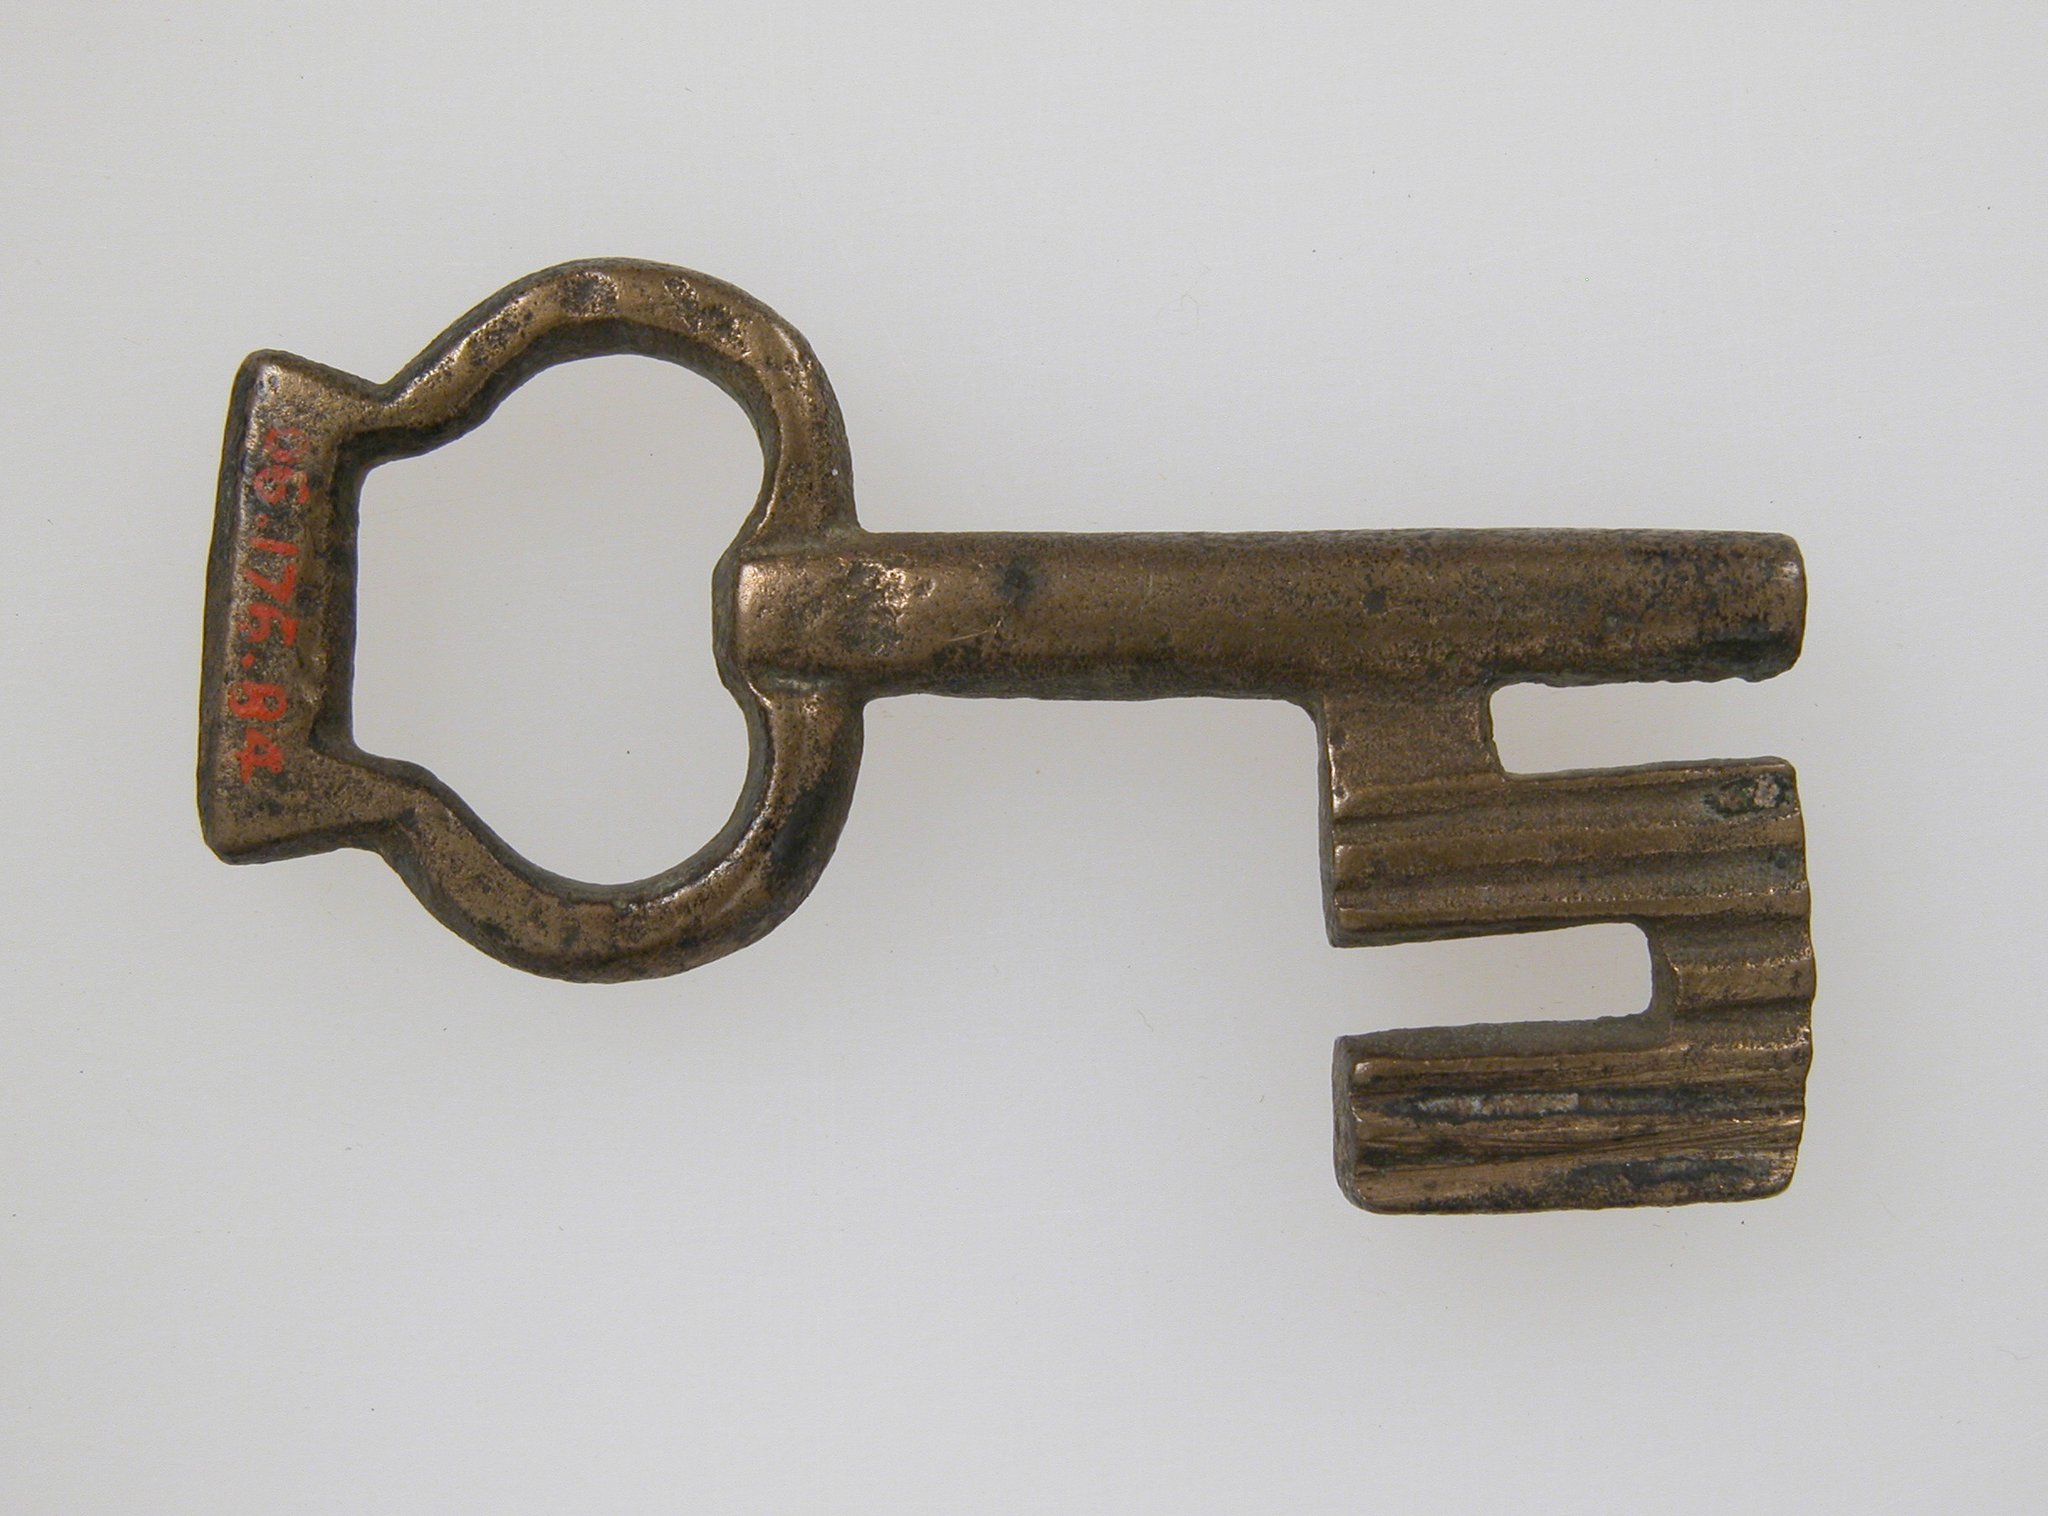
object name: key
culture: french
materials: copper alloy